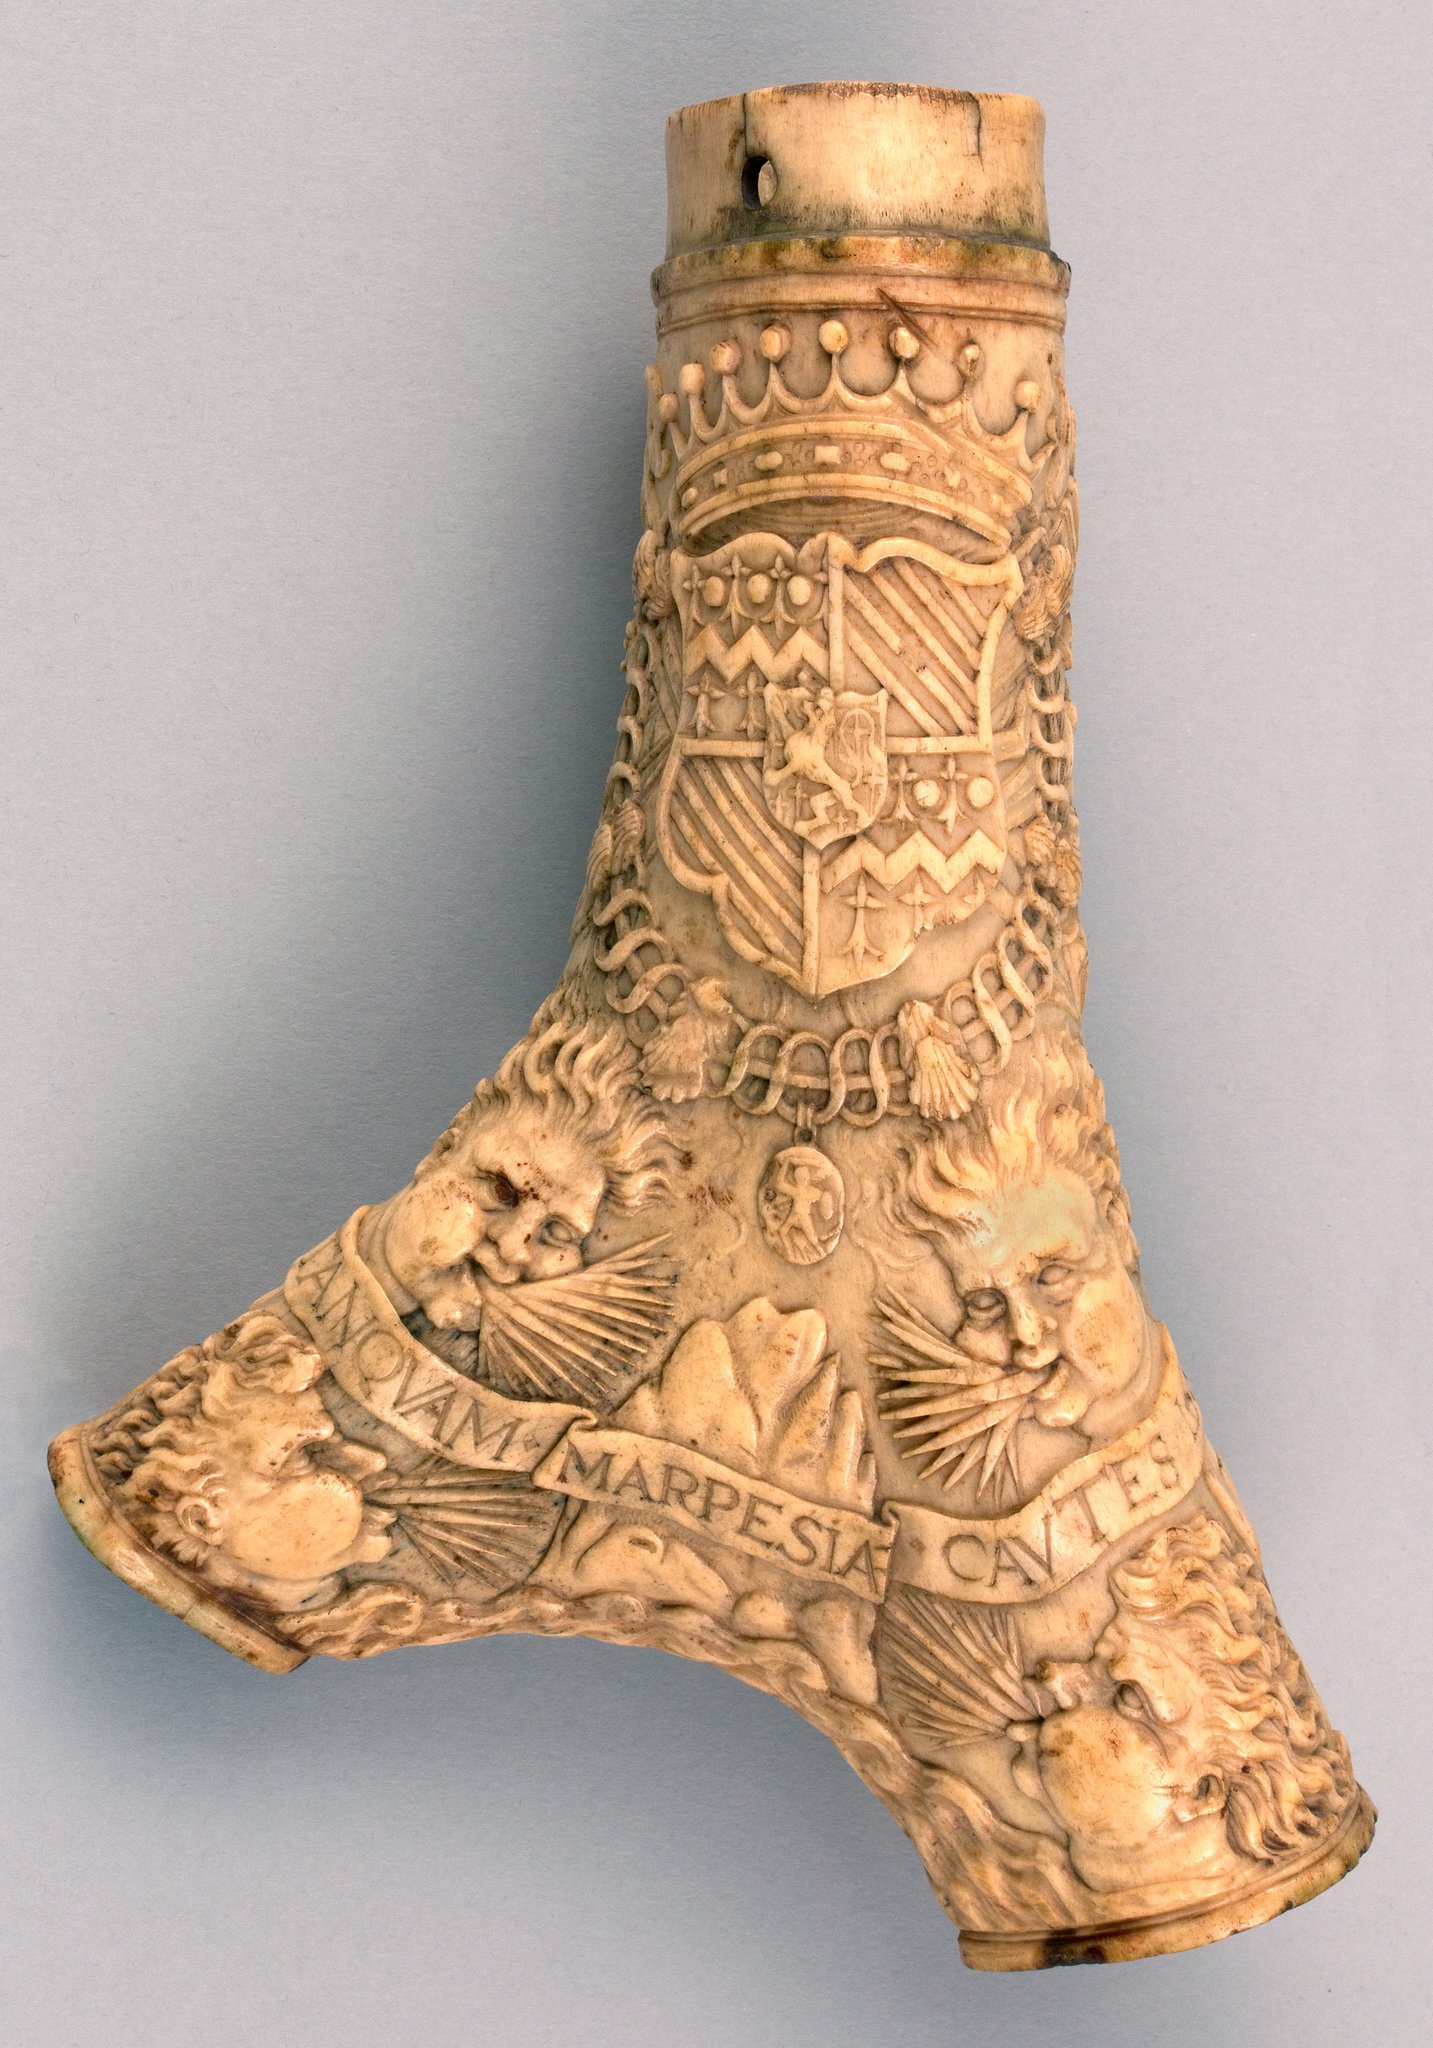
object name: powder flask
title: Powder Flask of Jacques de Silly (1513–1571)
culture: french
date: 1568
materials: antler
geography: france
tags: coat of arms